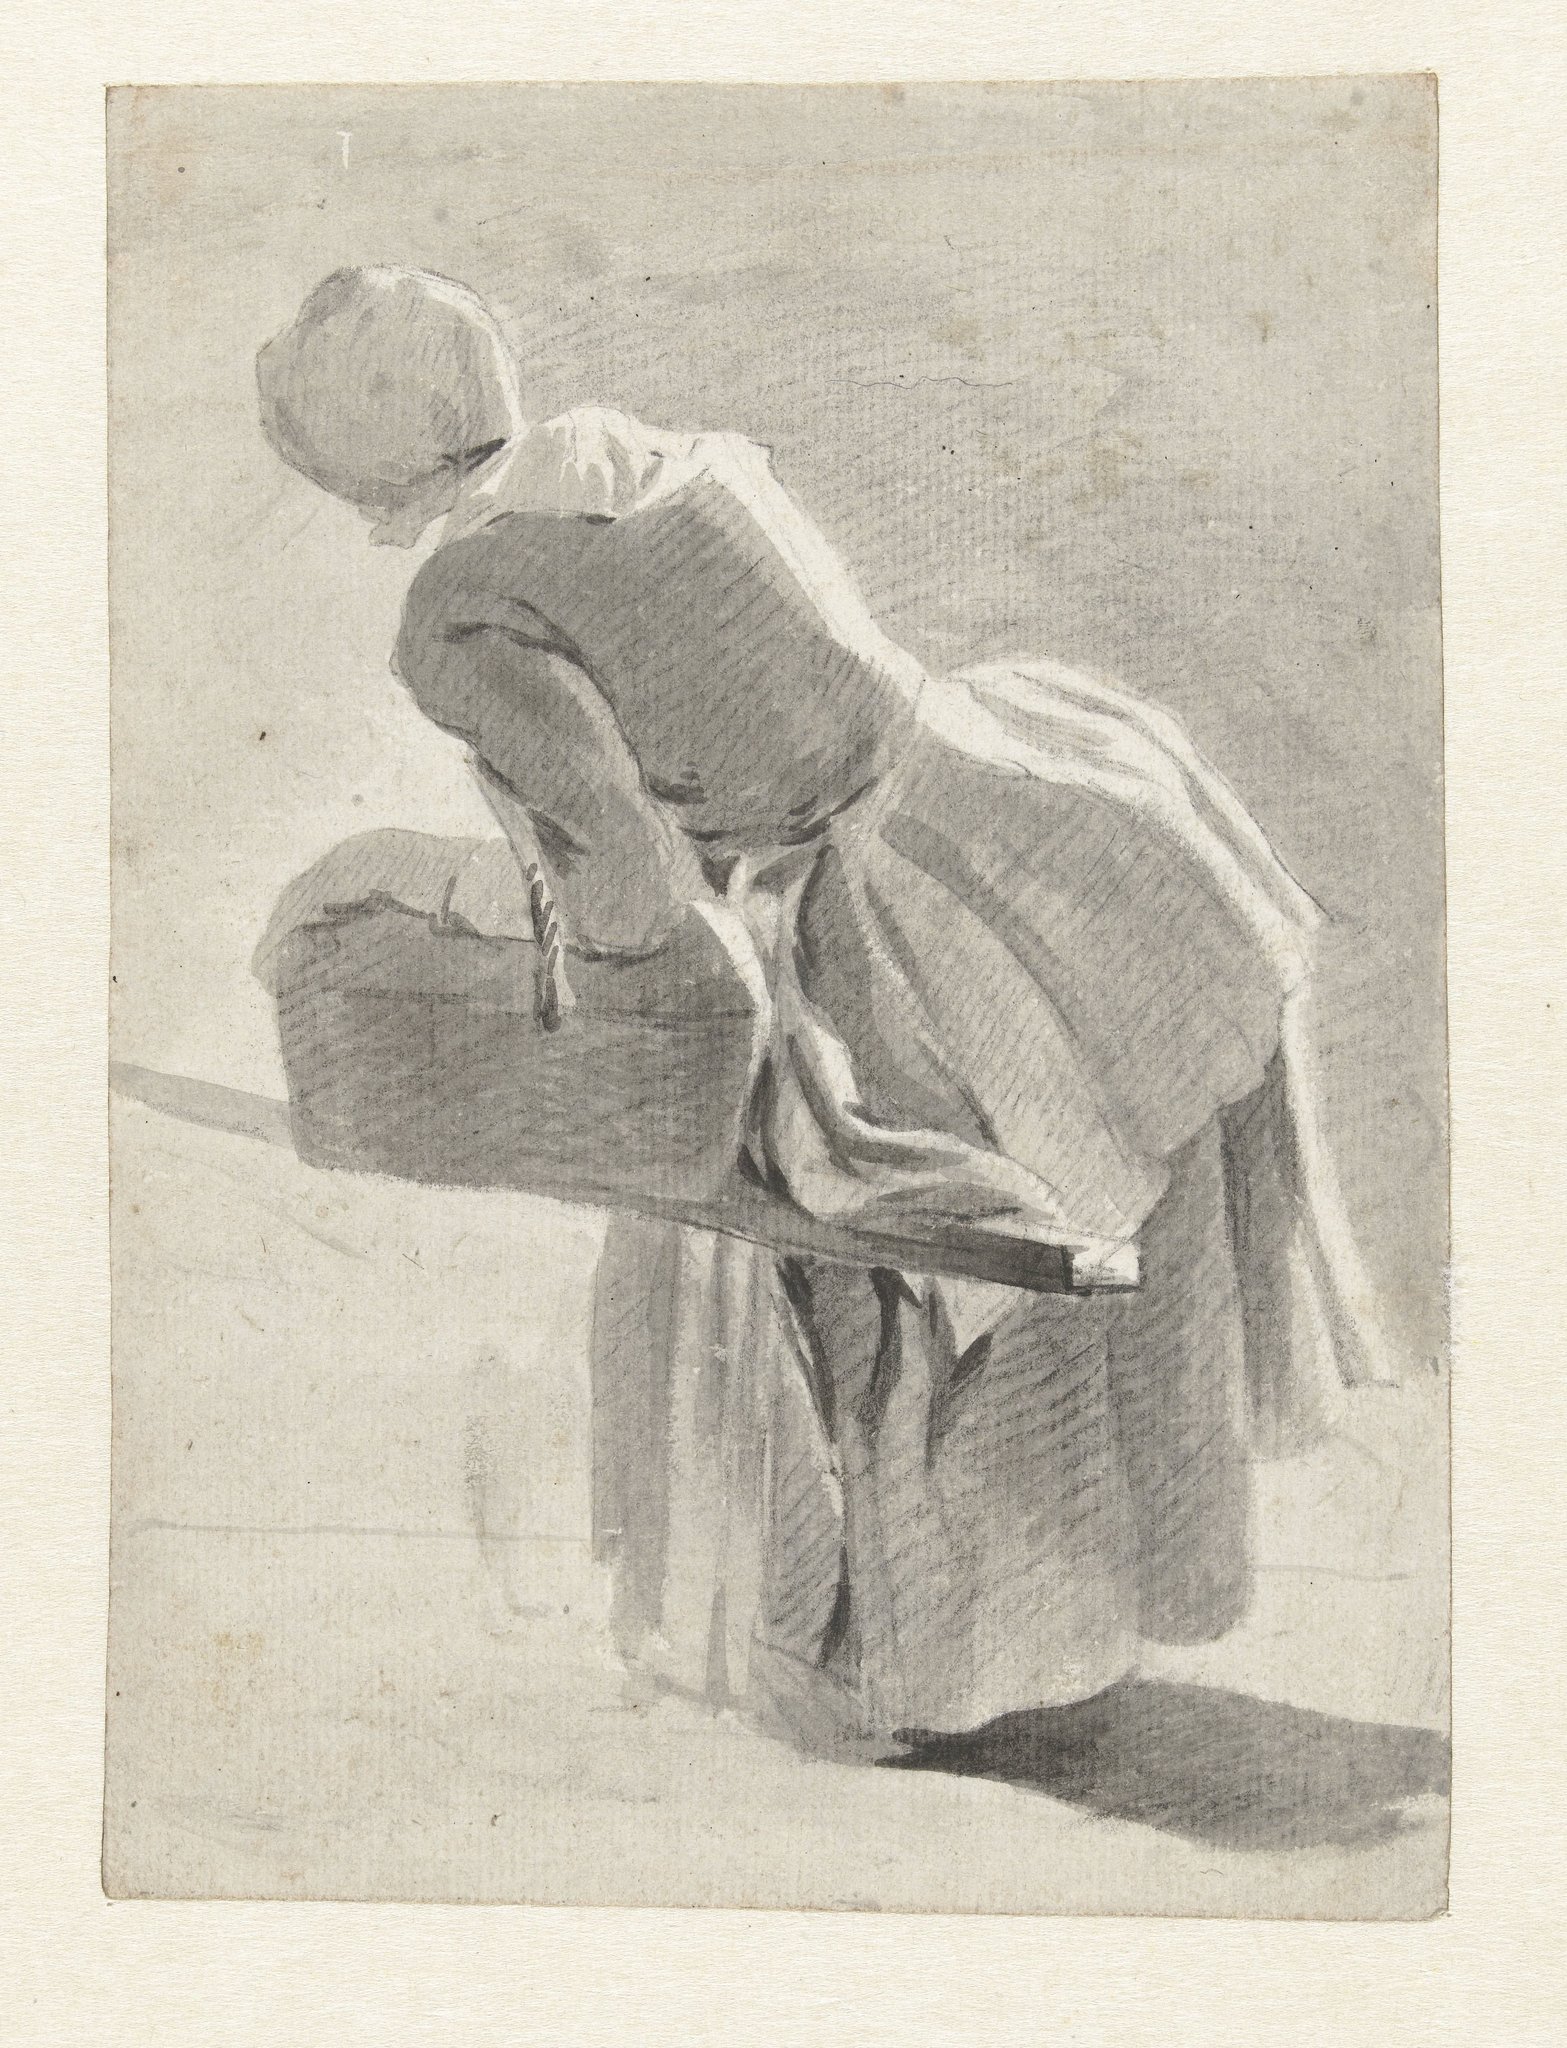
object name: drawing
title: Rustende dienstmaagd met een mand, op de rug gezien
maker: hermanus van brussel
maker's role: draughtsman, print maker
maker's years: 1763-1815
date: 1773-1815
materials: chalk, paper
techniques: brush